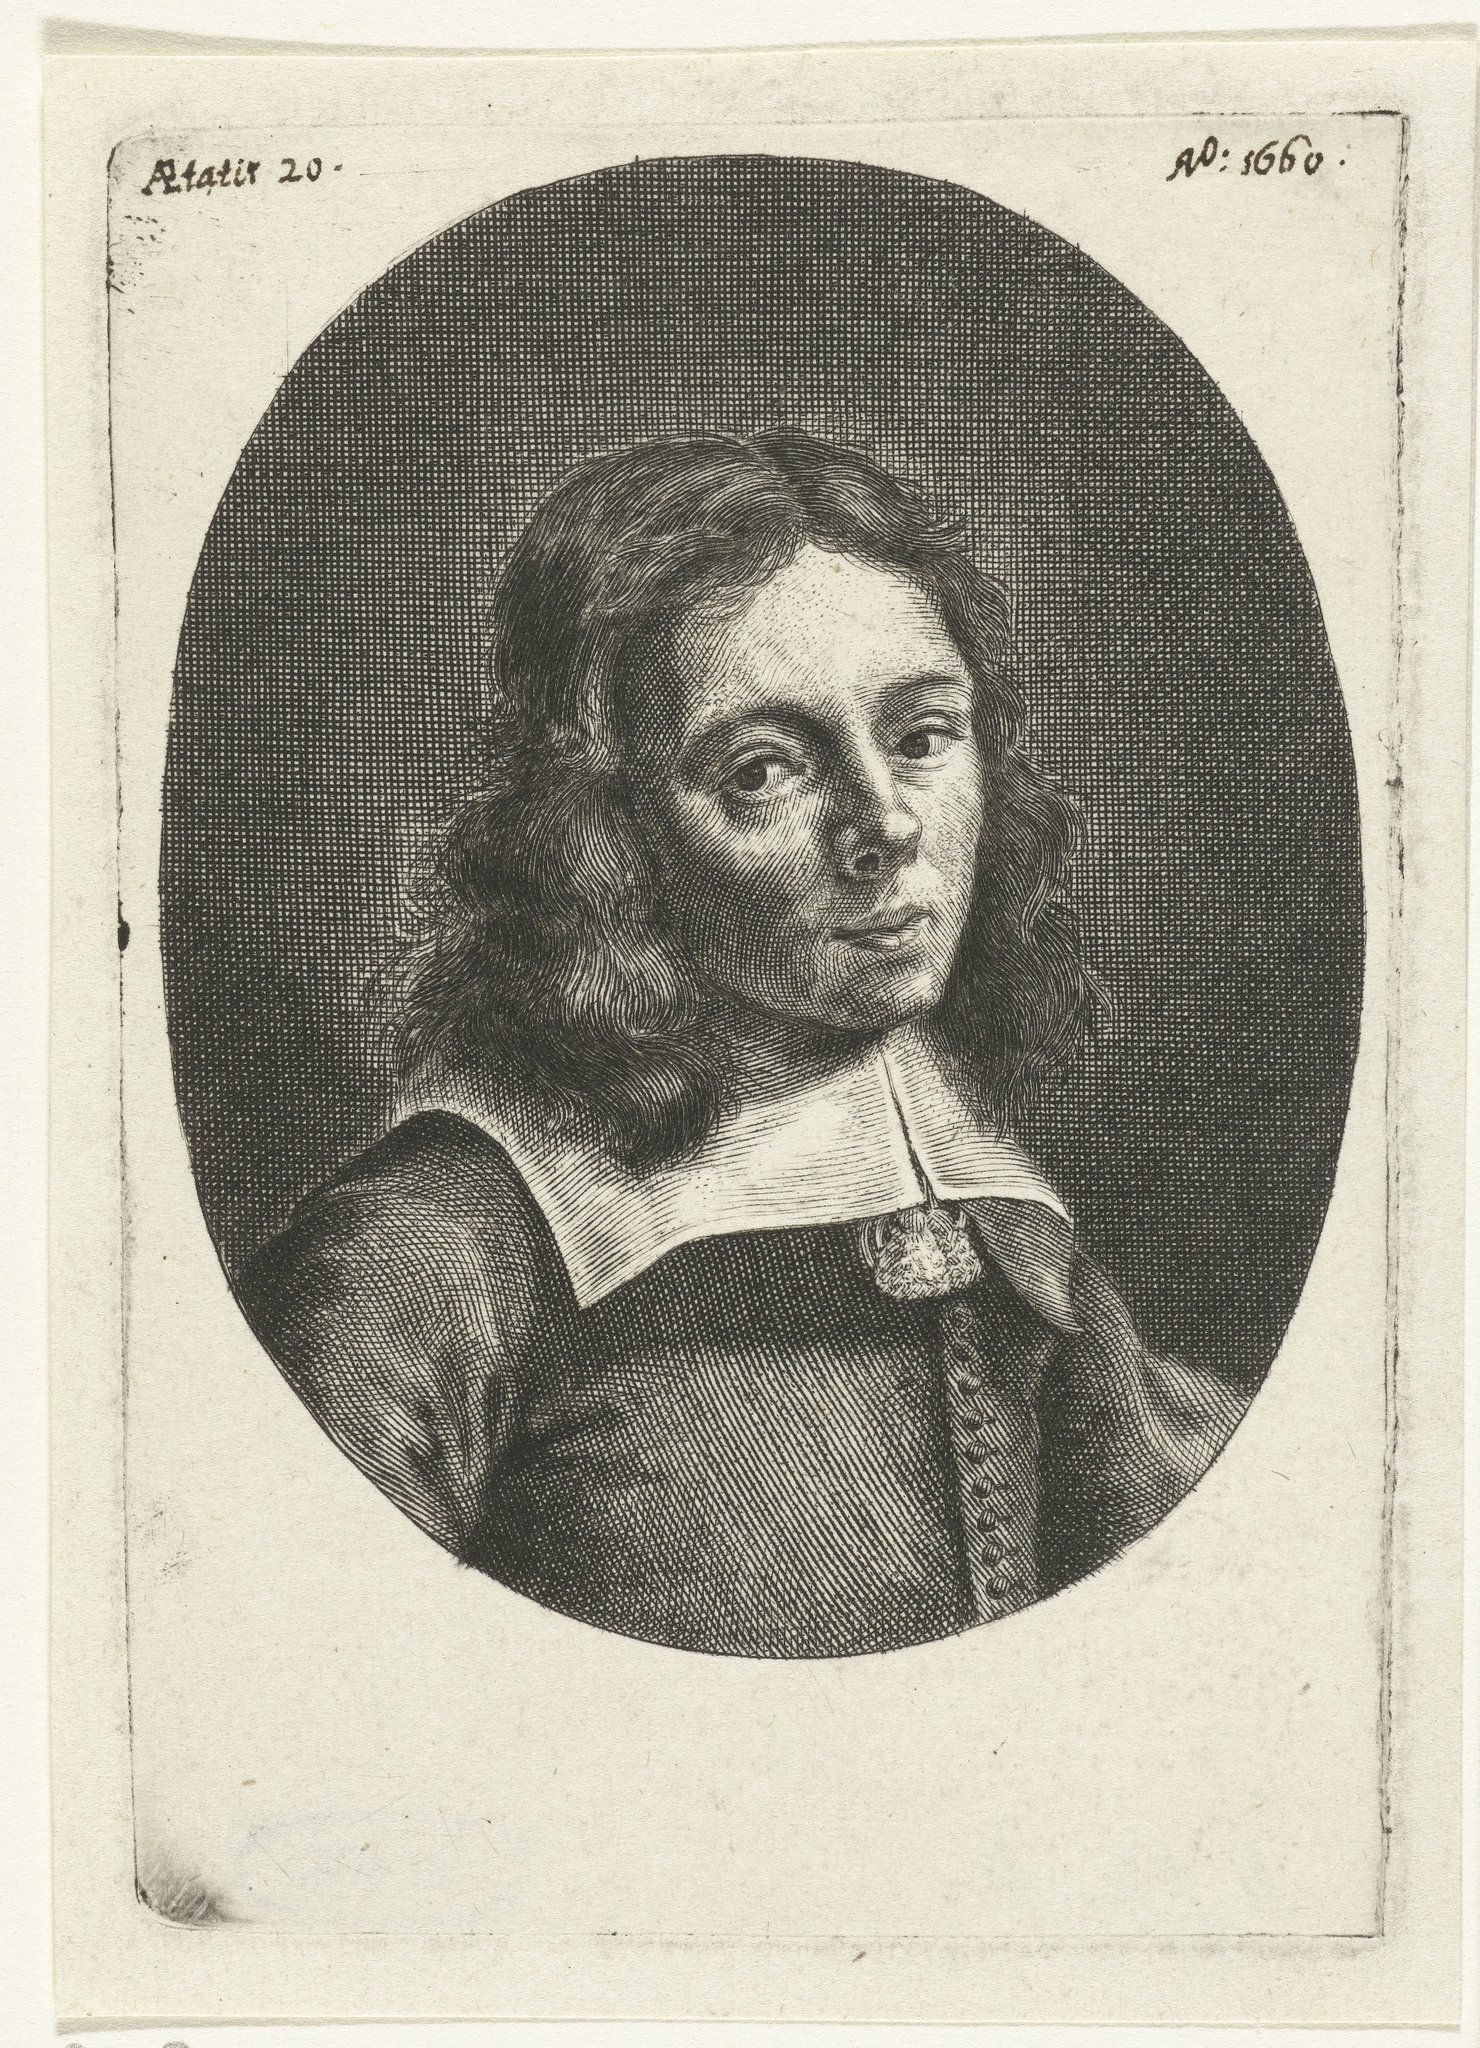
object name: print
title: Zelfportret op 20-jarige leeftijd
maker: hendrik bary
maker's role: draughtsman, print maker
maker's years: 1640-1707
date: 1660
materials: paper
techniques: engraving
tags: gouda, print maker, draughtsman, hendrik bary, portrait, self-portrait of artist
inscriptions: inscription: ‘Aetatis 20 A[nn]o: 1660’, collector's mark: Lugt 2228